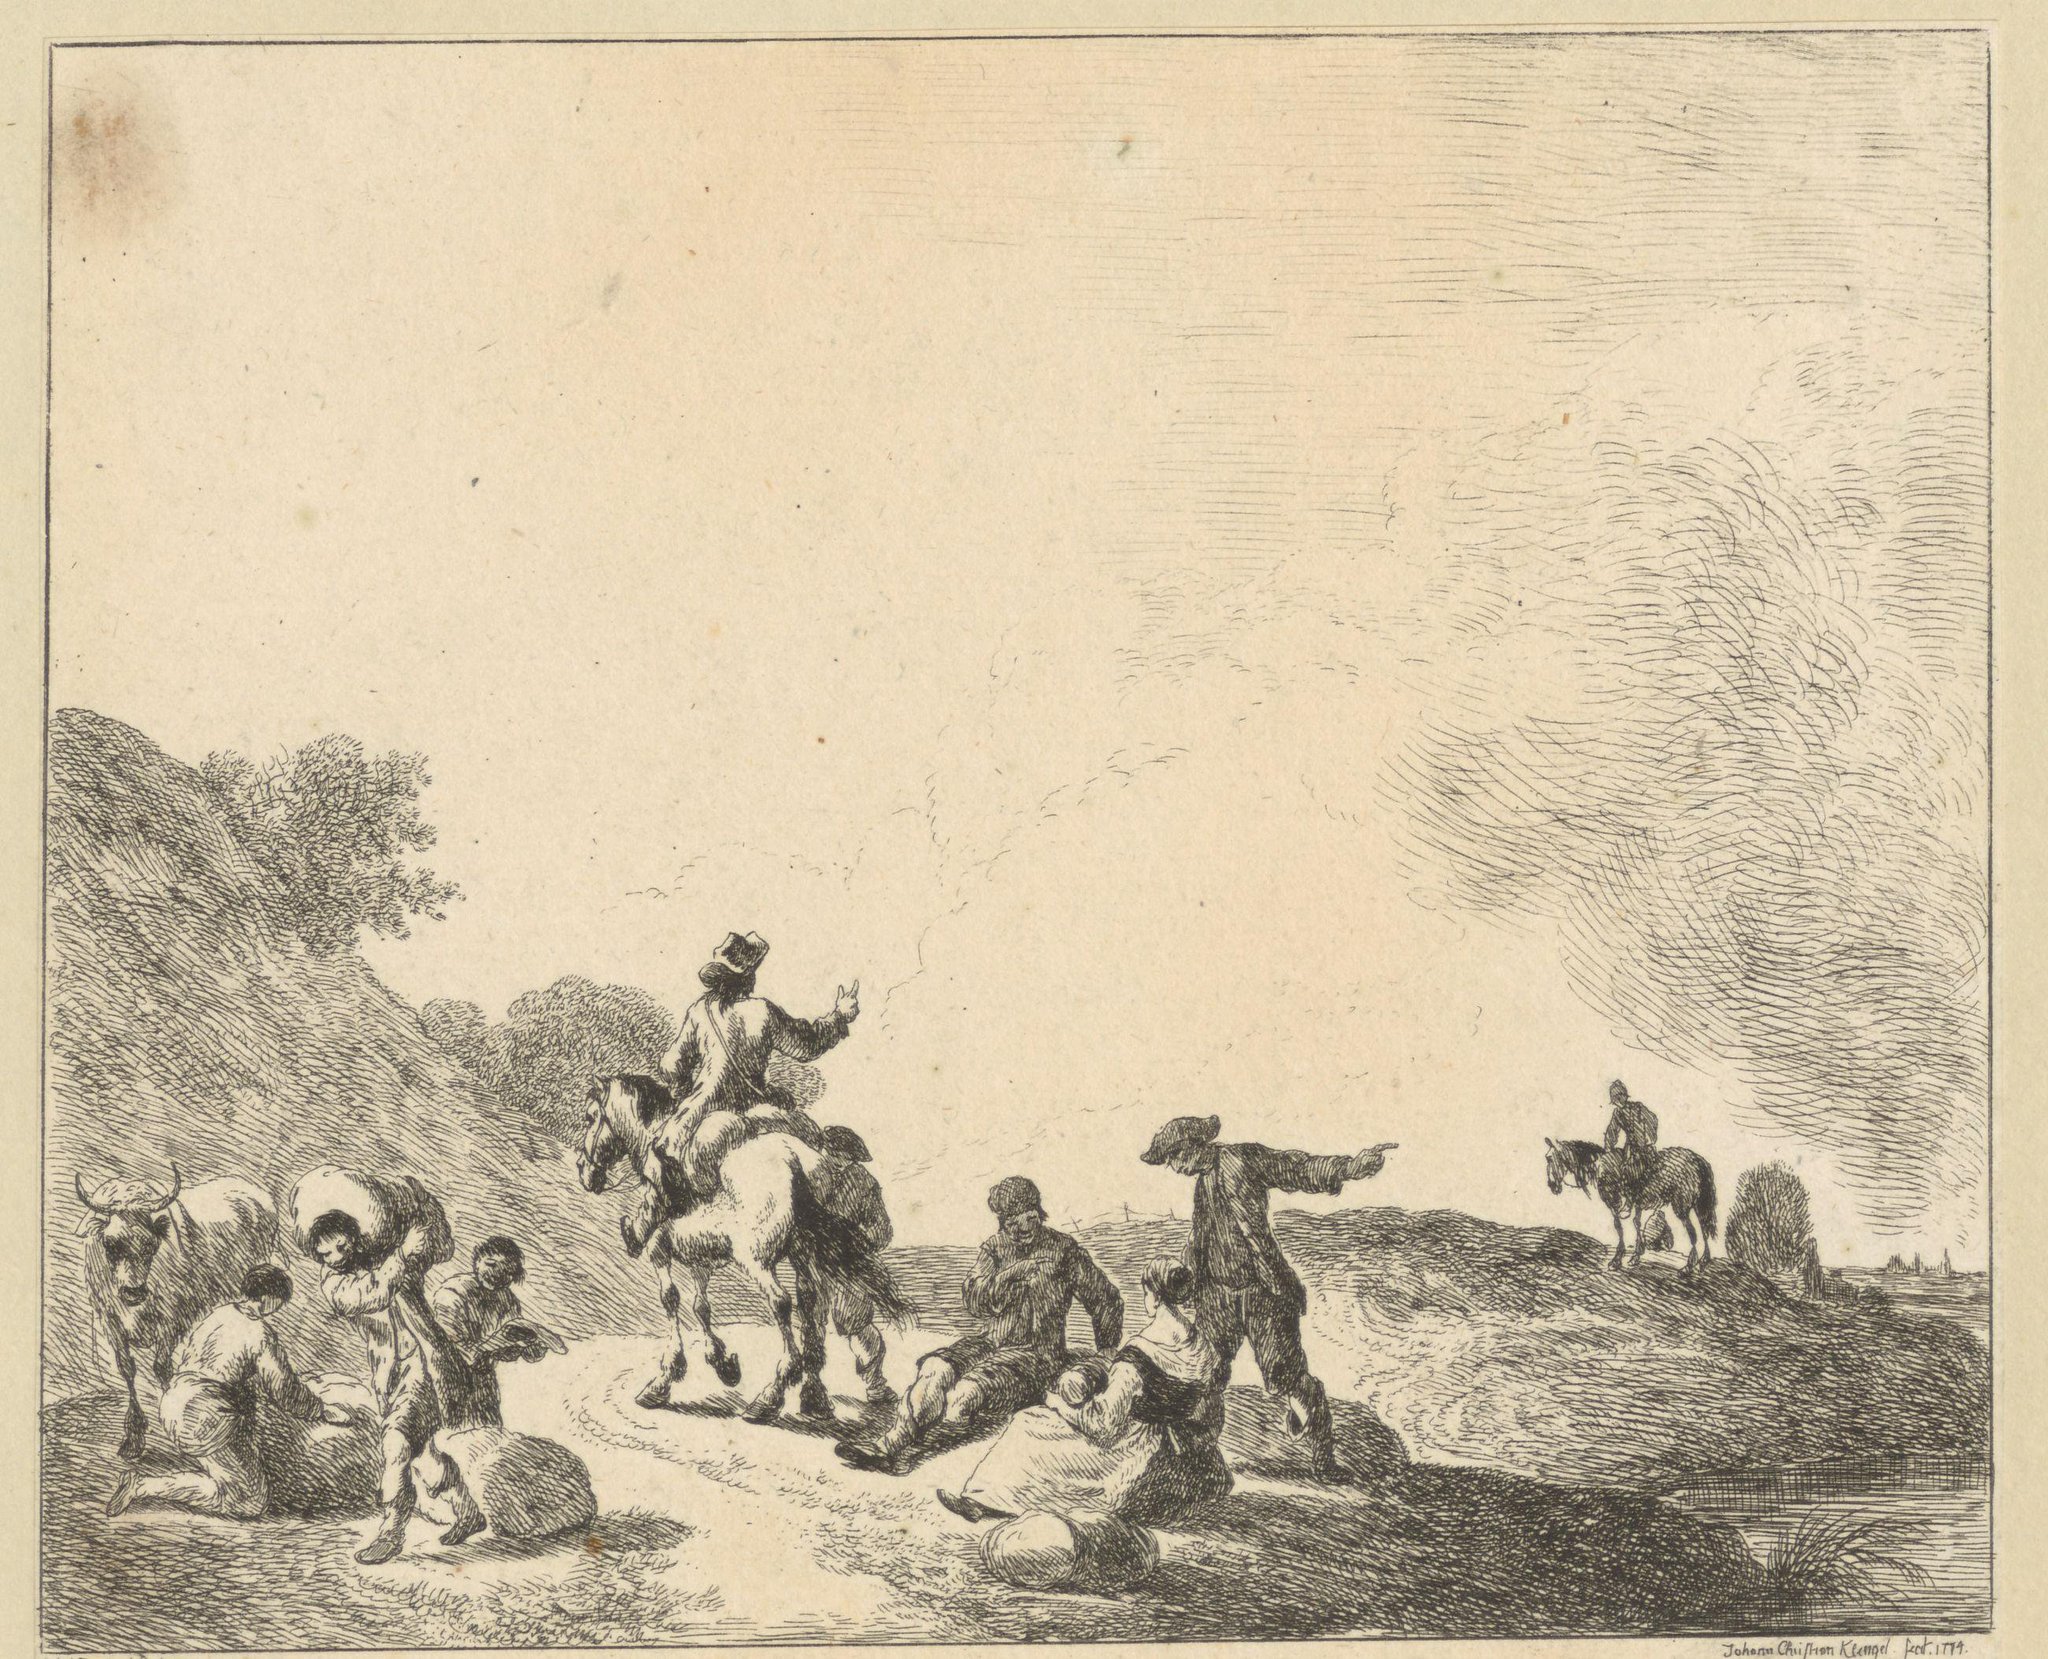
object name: print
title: Landschap met ruiters en rustende en werkende arbeiders langs een pad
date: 1774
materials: paper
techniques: etching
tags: riding a horse, ass, or mule; rider, horseman, low hill country, (traveller) resting in the open air, transporting ~ harvest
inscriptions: collector's mark: Lugt 240